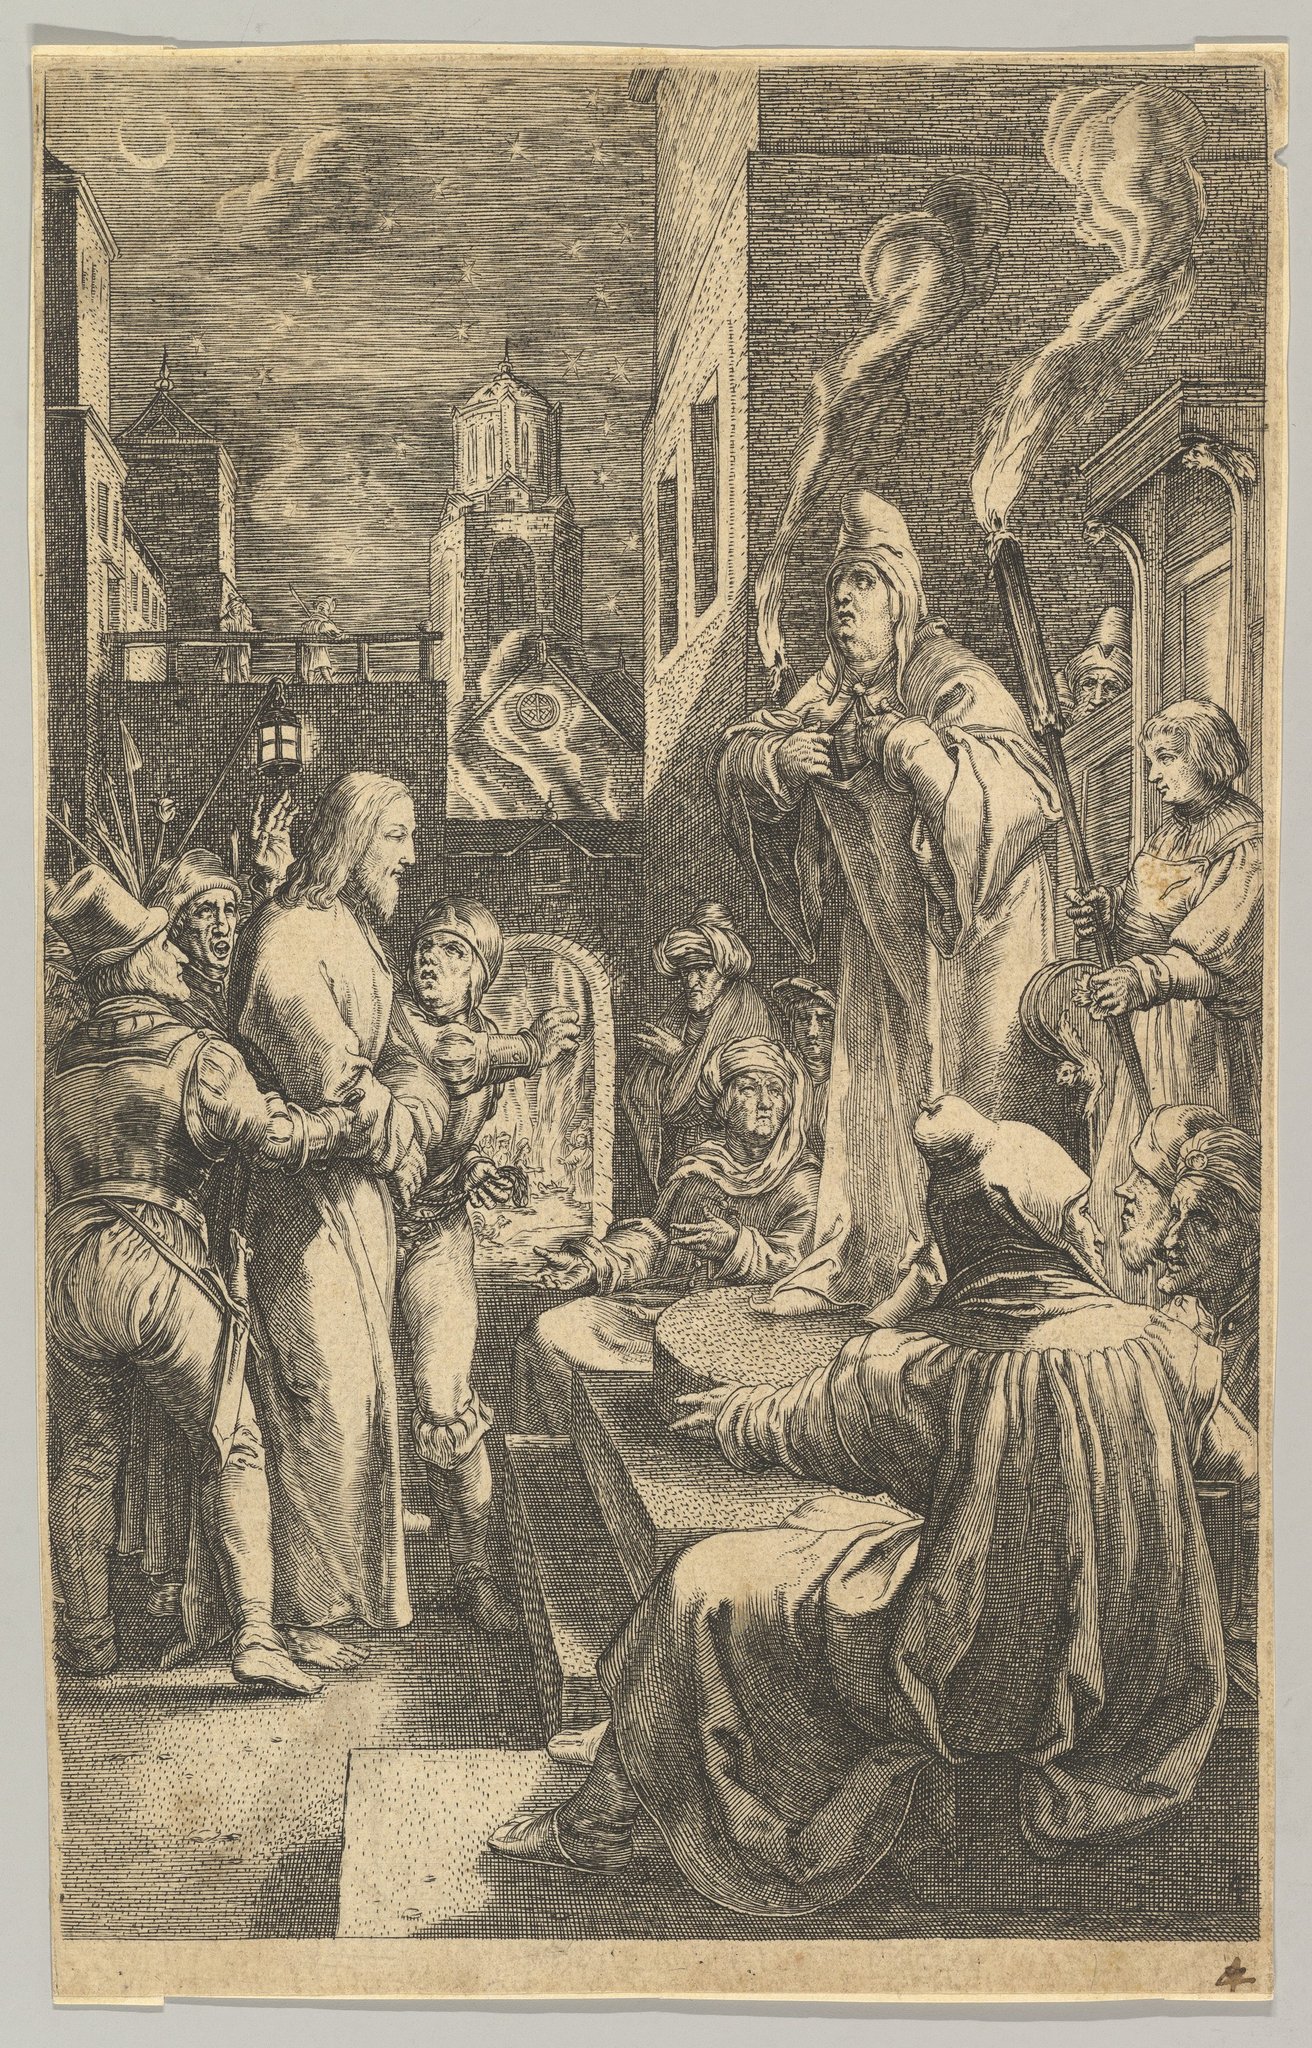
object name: print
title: Christ before Caiaphas, from "The Passion of Christ"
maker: ludovicus siceram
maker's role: artist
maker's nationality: flemish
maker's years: 1618-1628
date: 1623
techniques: engraving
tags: men,christ